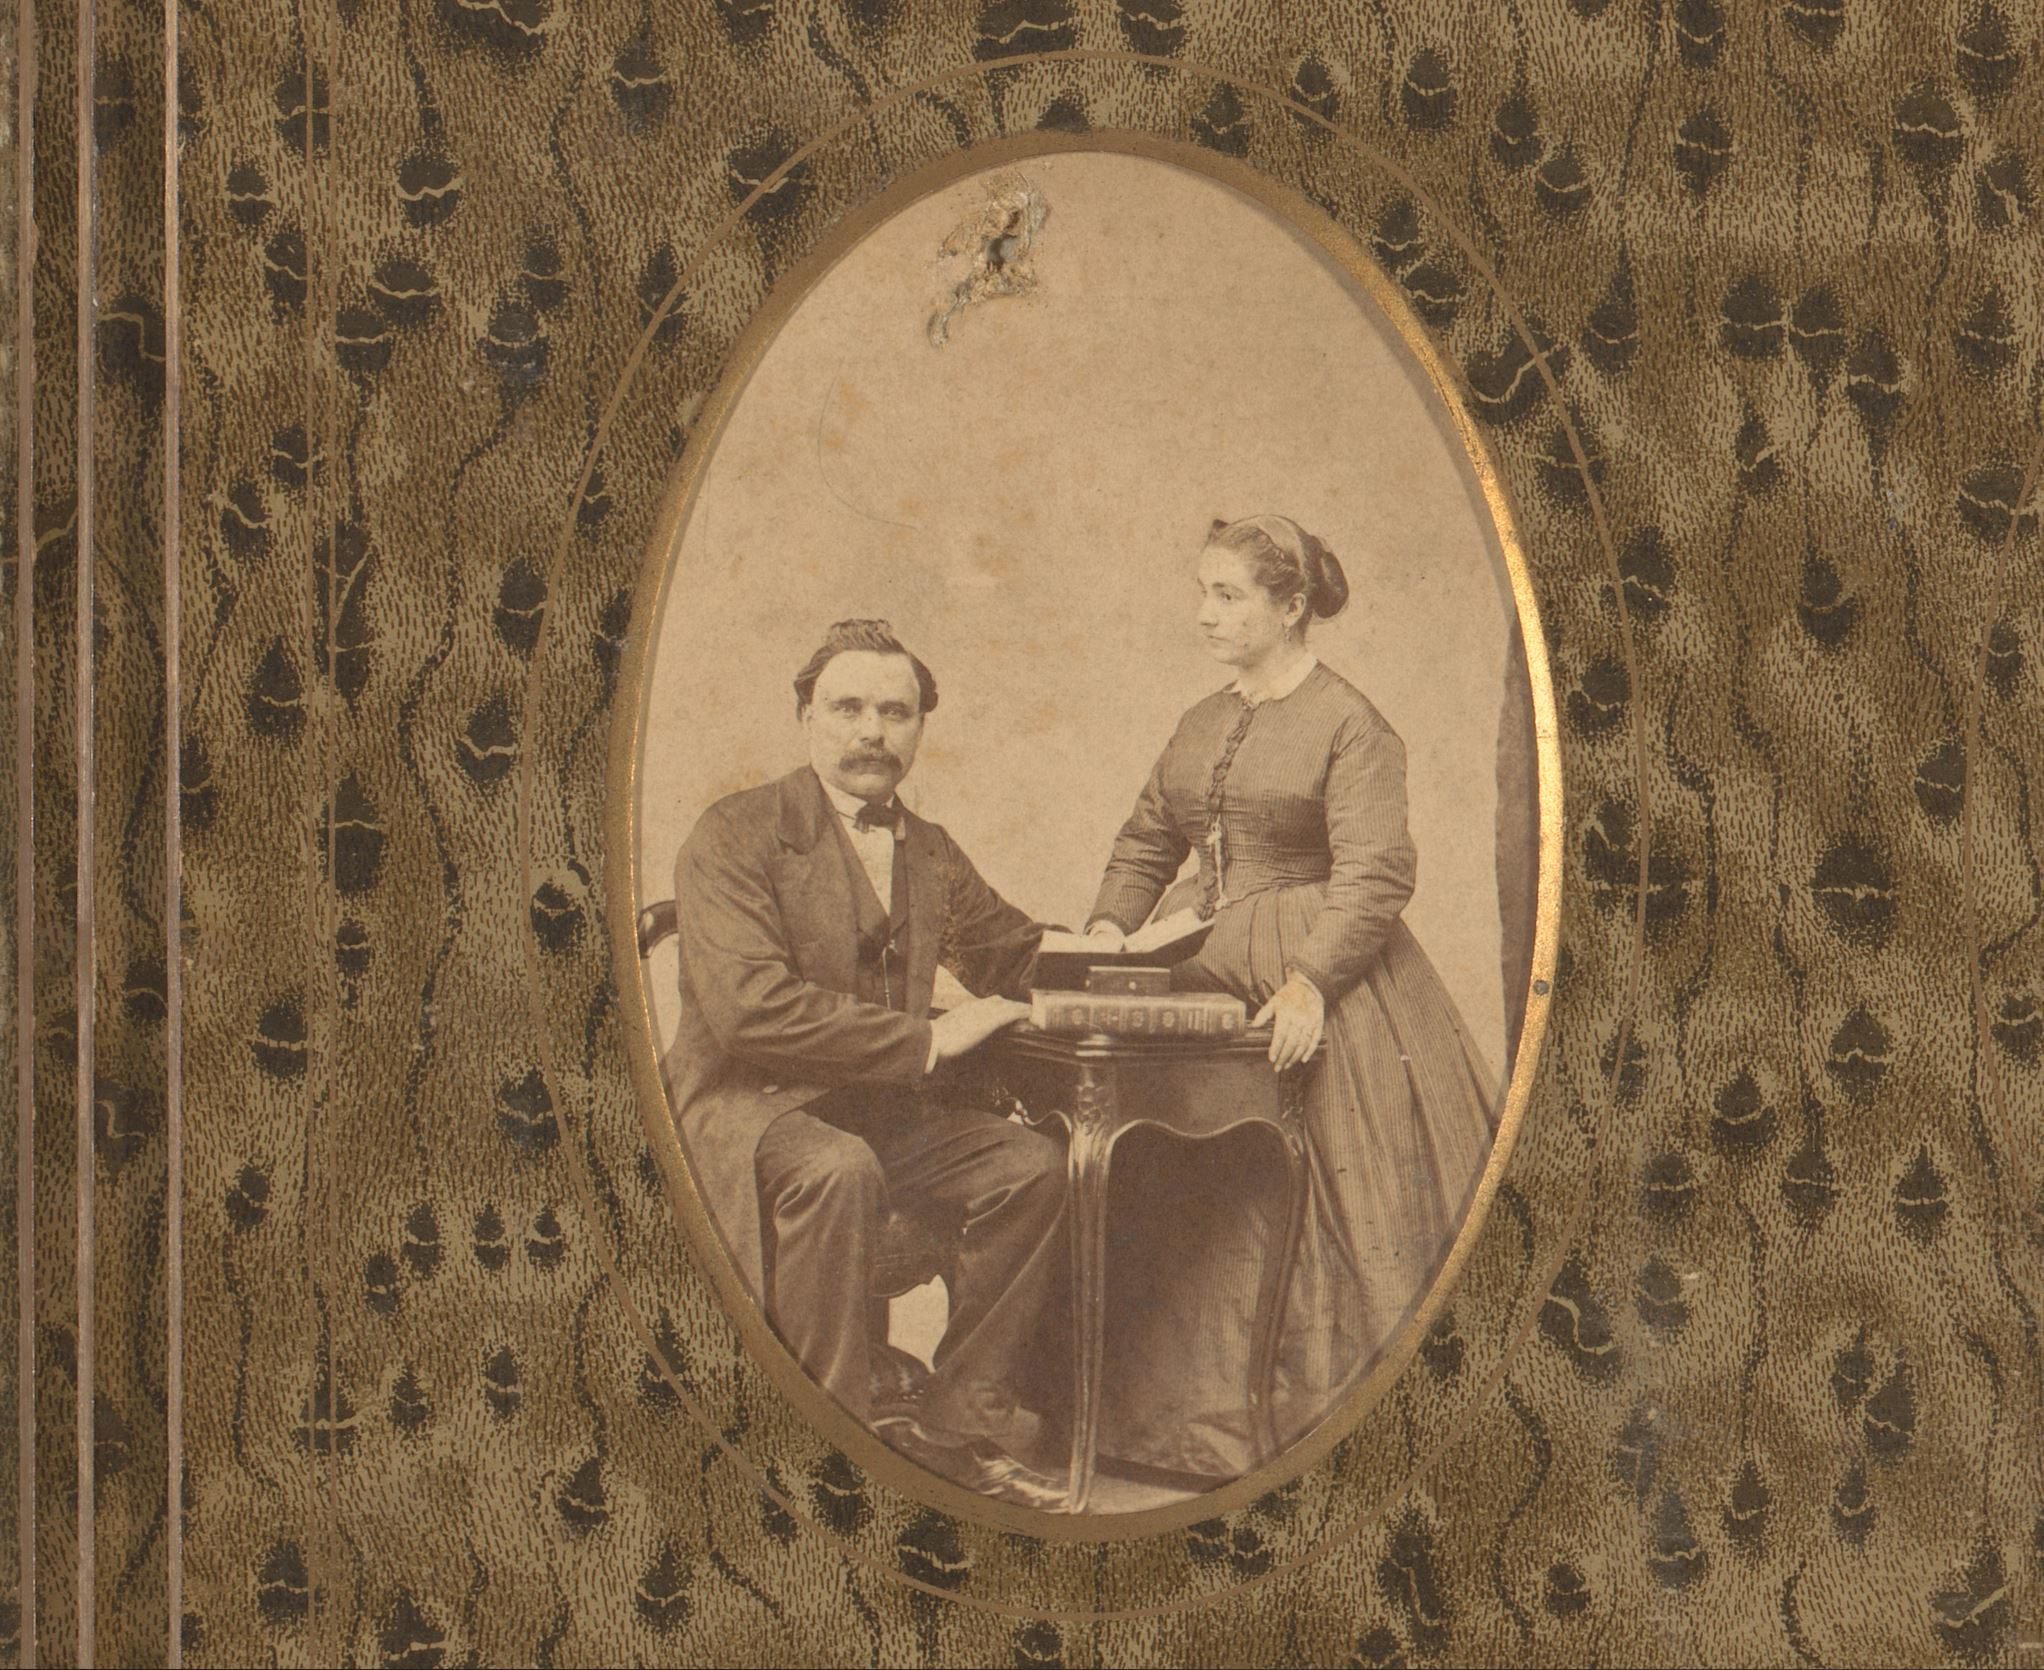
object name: carte de visite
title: Portret van een zittende man aan een tafel met boeken en een staande vrouw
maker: merienne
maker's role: fotograaf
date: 1850-1900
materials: cardboard, photographic support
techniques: albumen print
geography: grenoble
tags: historical persons - bb - woman, historical persons, table, book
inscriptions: inscription: ‘MERIENNE/ PHOTOGRAPHE/ Rue Lafayette, 4/ GRENOBLE’, annotation: ‘[.]rtune’